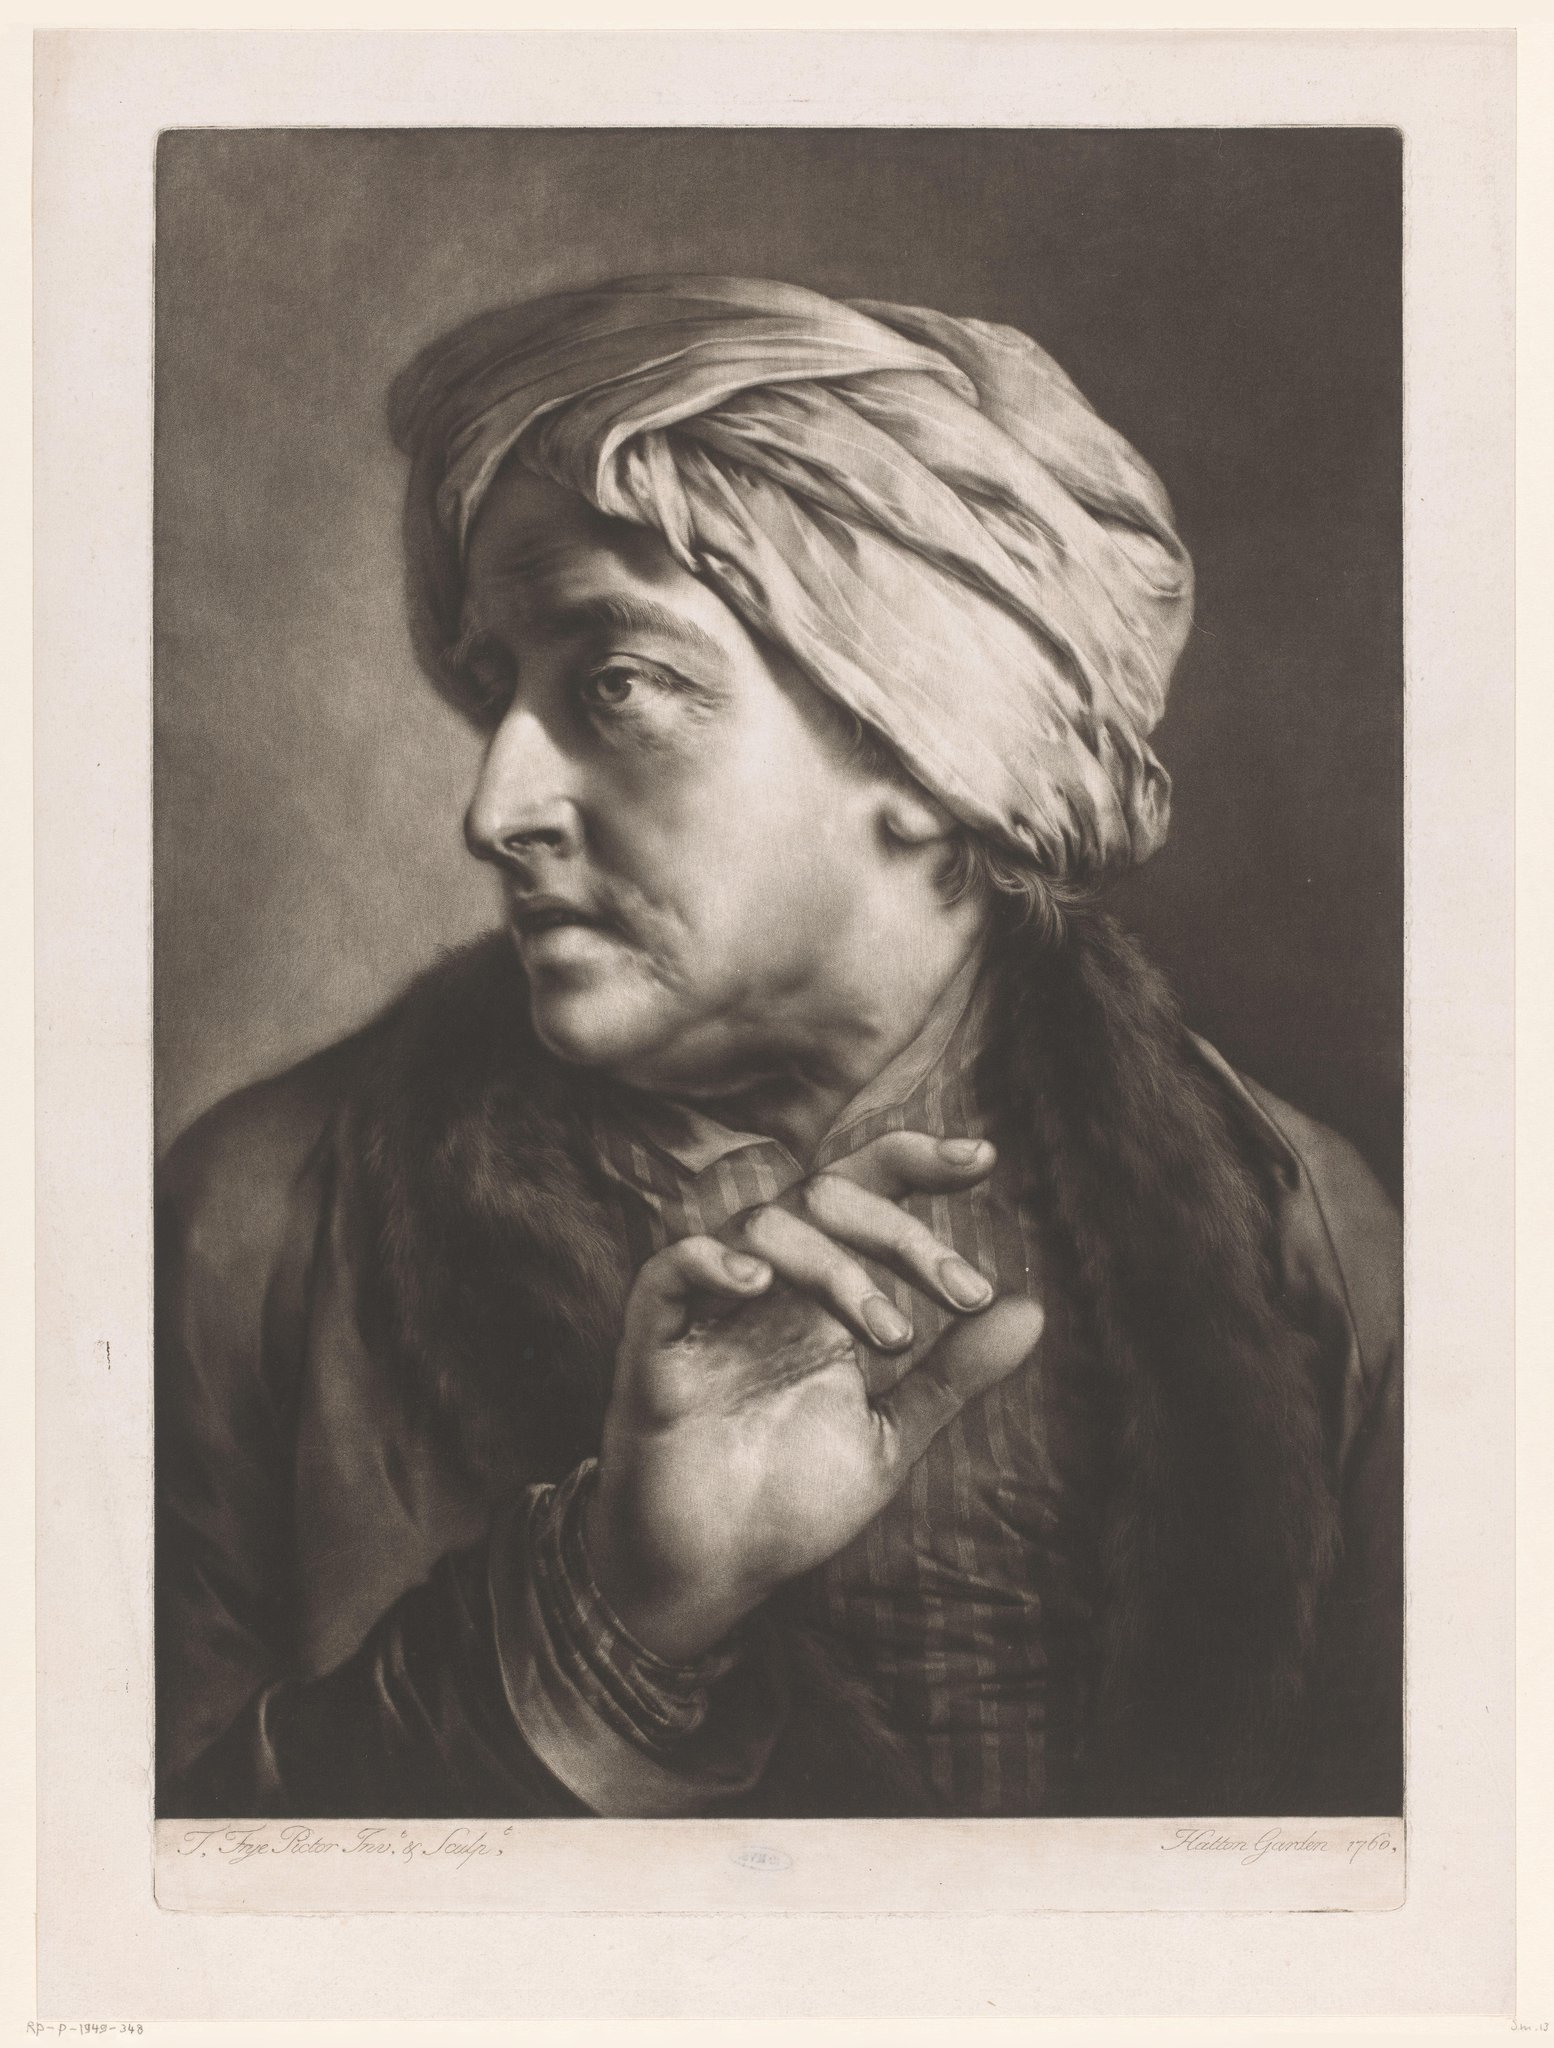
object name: print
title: Life-sized Heads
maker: thomas frye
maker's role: print maker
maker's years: 1710-1762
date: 1760-1762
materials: paper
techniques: mezzotint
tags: adult man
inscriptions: collector's mark: Lugt 2228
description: Frye voerde portretten uit in olieverf, pastel en mezzotint. Deze prent is deel van een serie van achttien levensgrote koppen met verschillende uitdrukkingen en in verschillende houdingen, uitgegeven tussen 1760-1762.